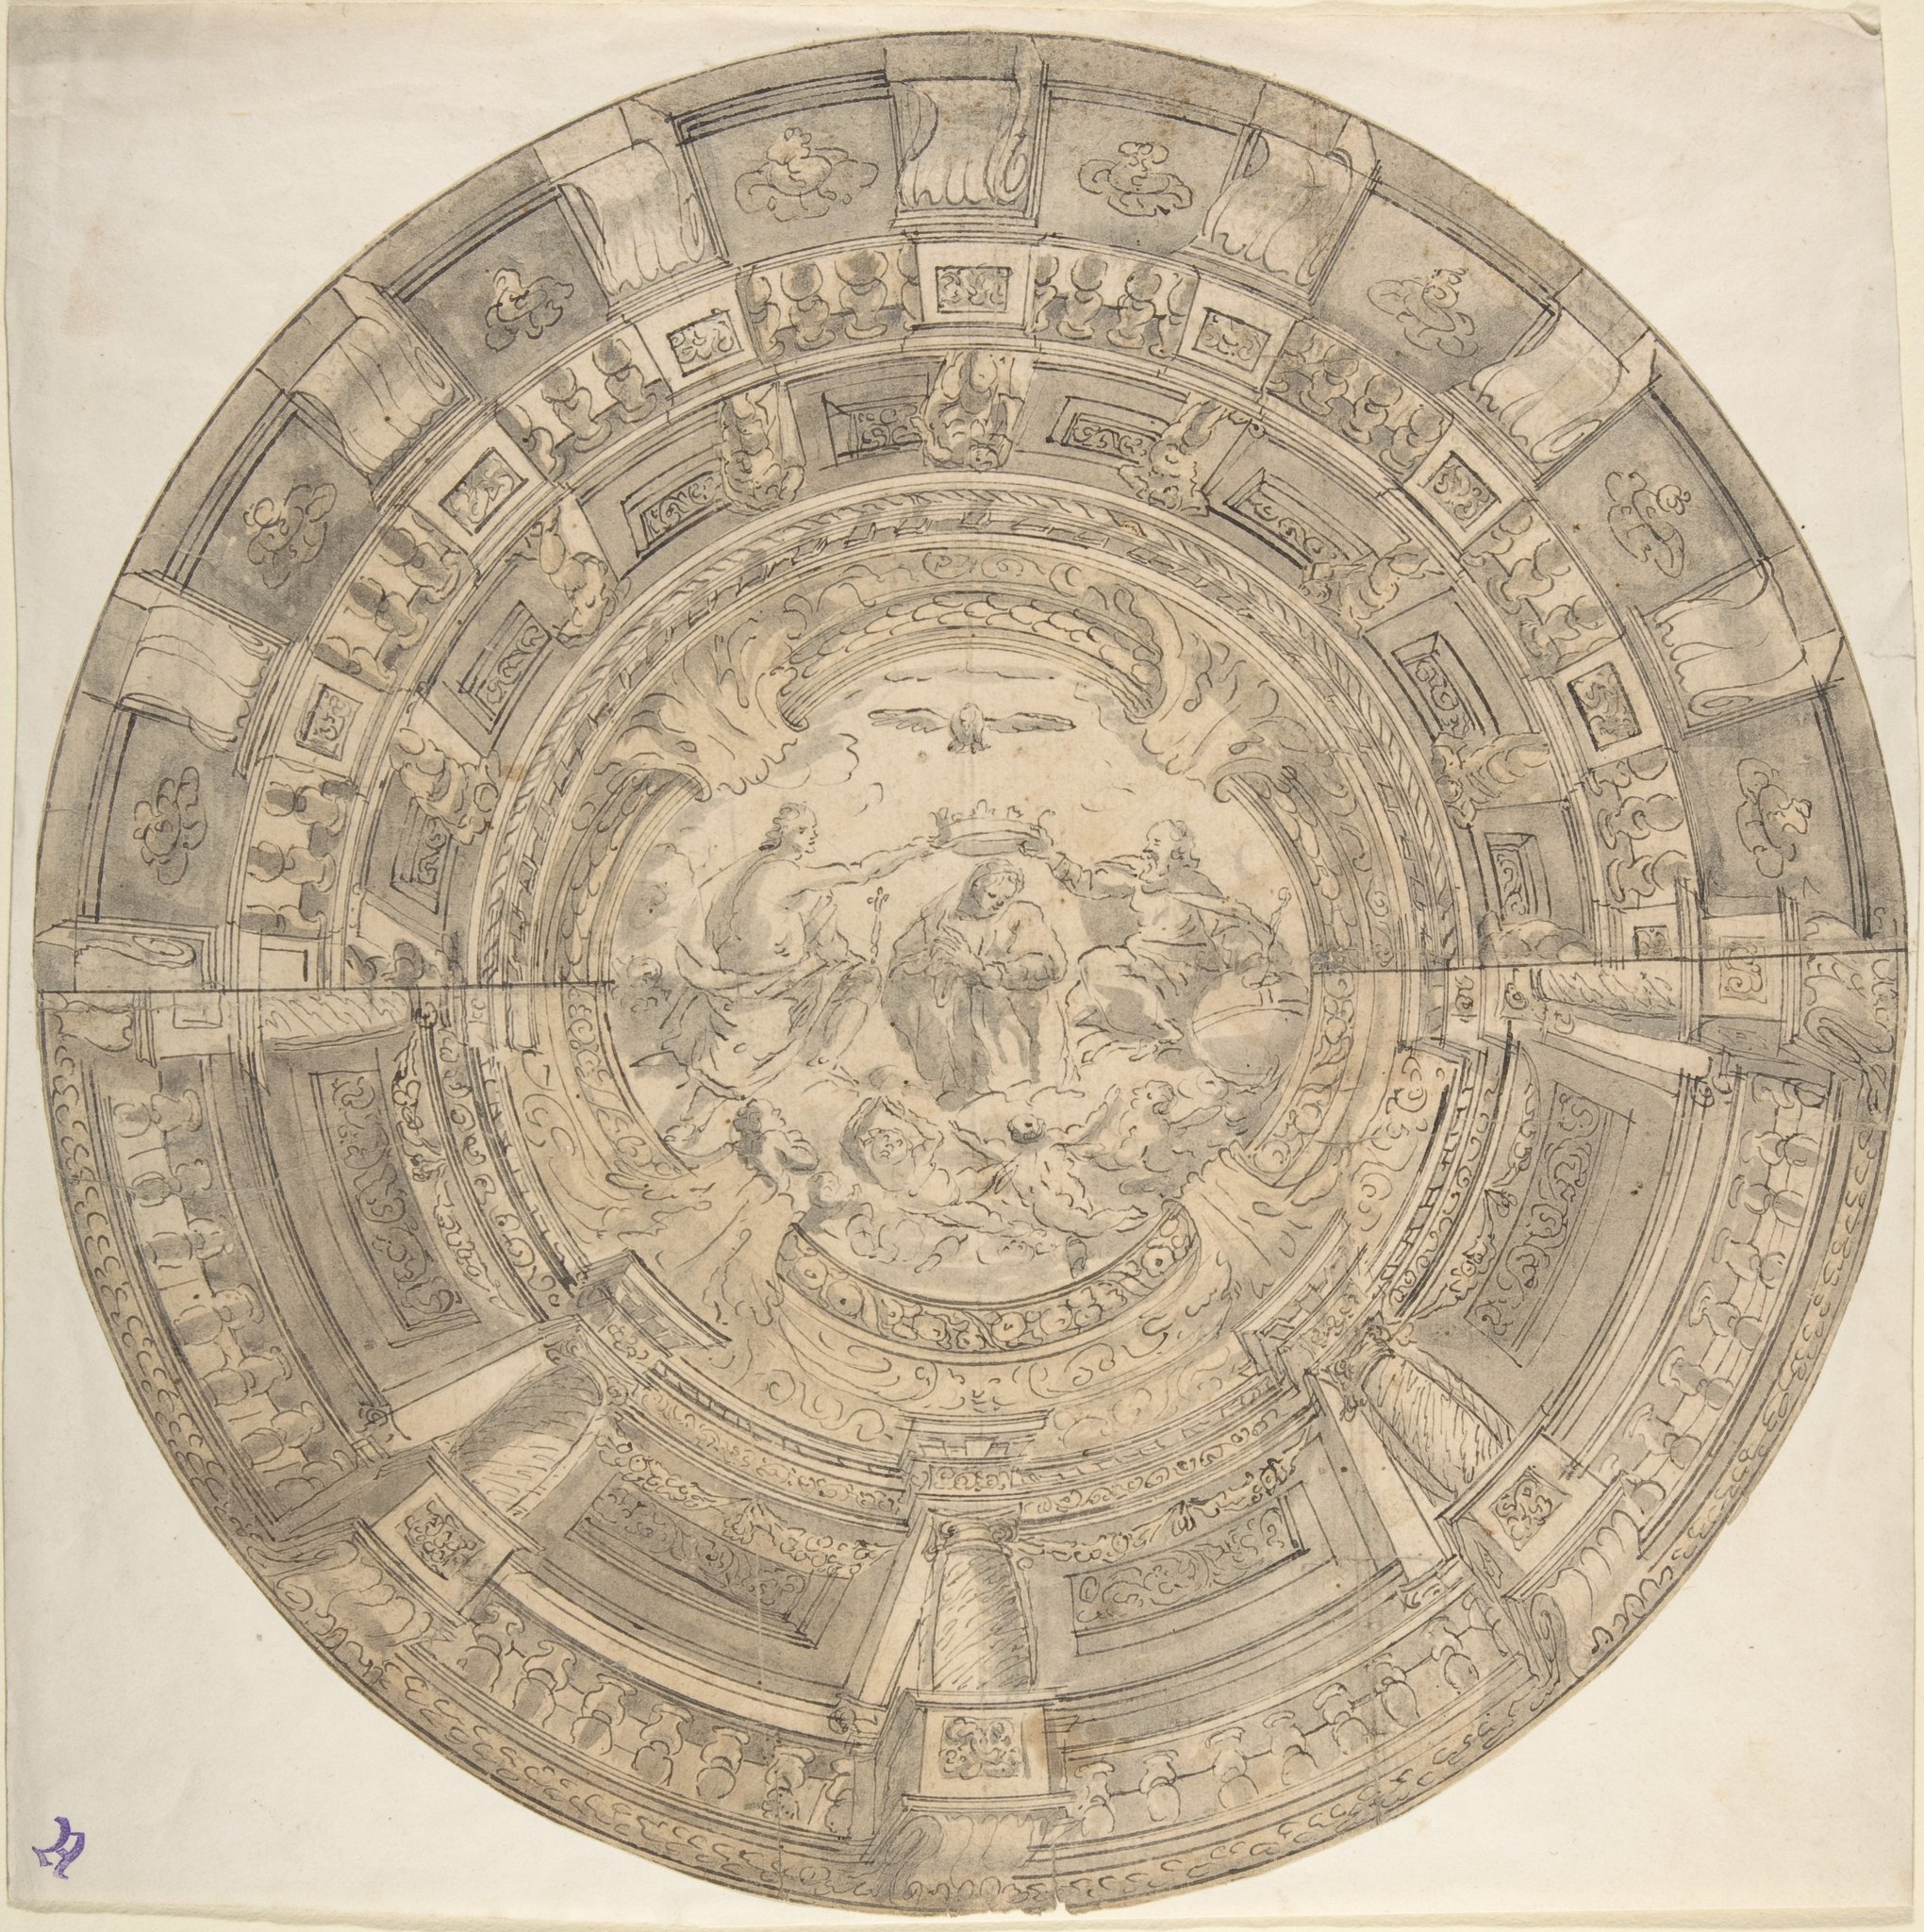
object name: drawing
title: Trompe L'Oeil Ceiling with the Coronation of the Virgin and a Variant for the Decoration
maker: anonymous, italian, 17th century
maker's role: artist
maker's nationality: italian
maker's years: 1600-1700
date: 1601-1700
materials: ink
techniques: brush, pen, wash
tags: assumption of the virgin